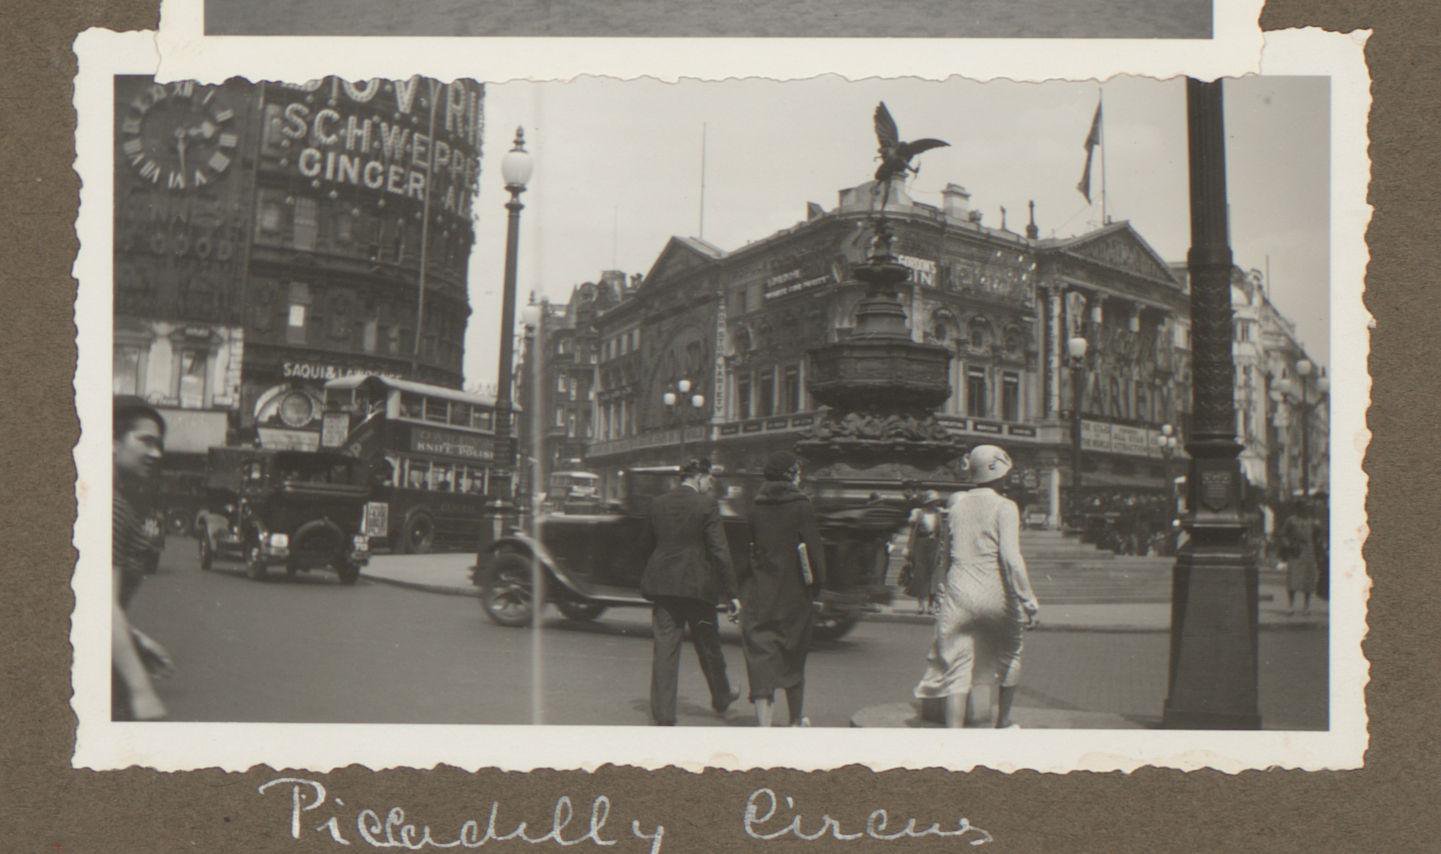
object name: album leaf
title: Gezicht op Piccadilly Circus, Londen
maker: Anonymous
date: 1906-1933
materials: paper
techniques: gelatin silver print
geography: london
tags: square, place, circus, etc.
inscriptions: inscription: ‘Piccadilly Circus’